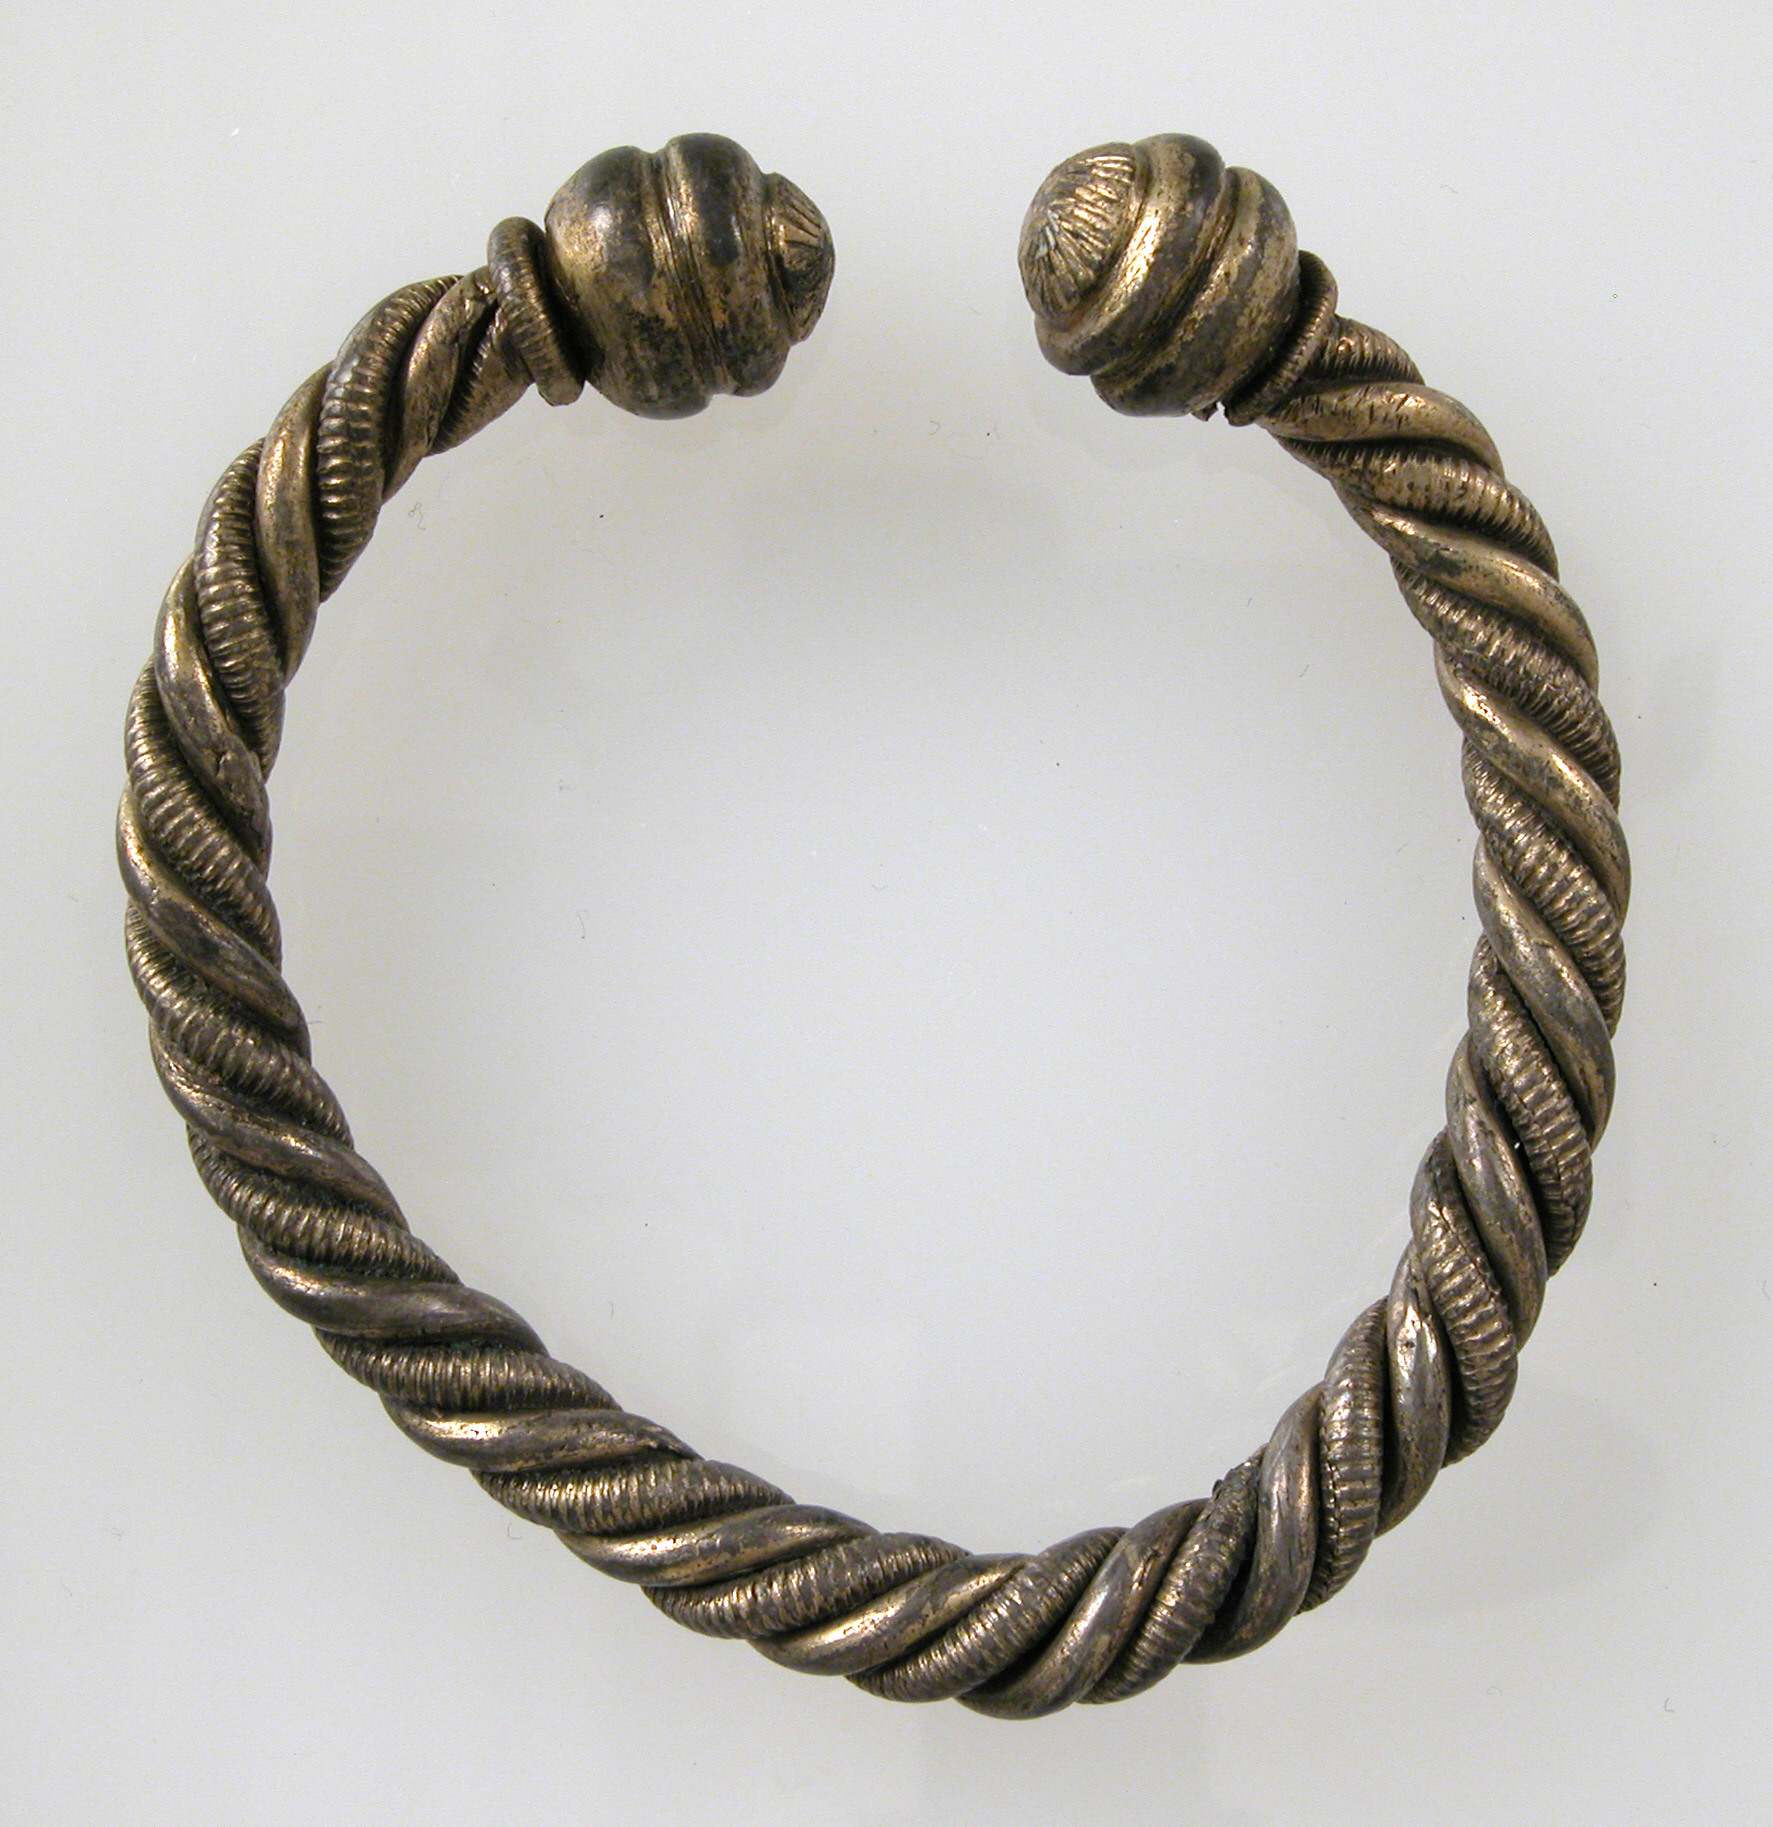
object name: bracelet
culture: pontine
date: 201-300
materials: silver gilt